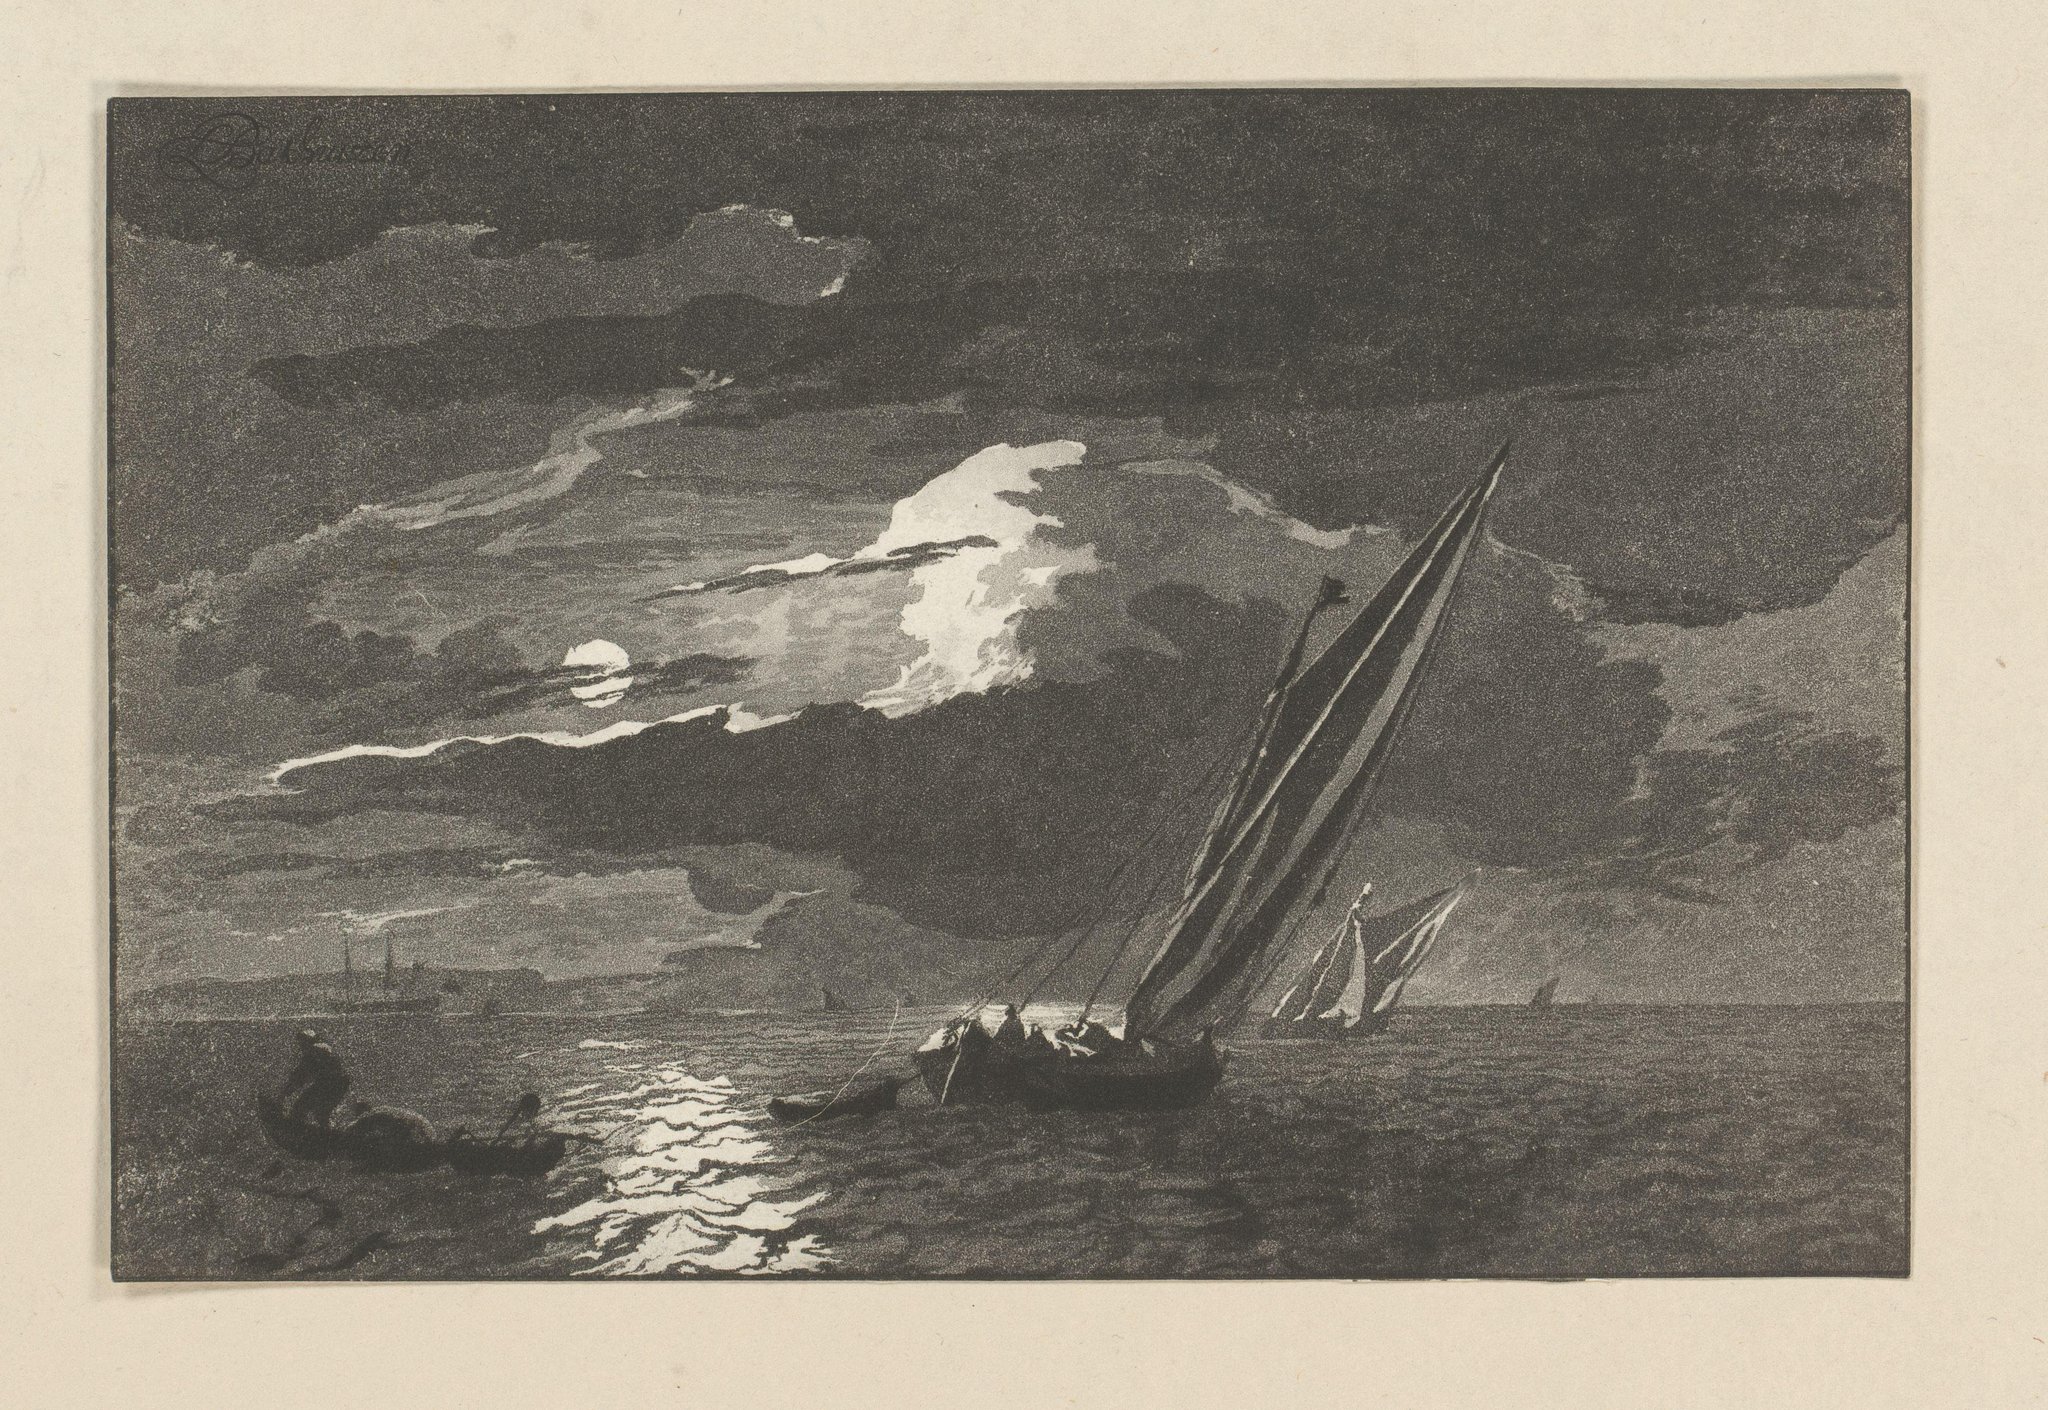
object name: print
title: Zeegezicht met volle maan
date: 1779-1781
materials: paper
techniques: transfer, print drawing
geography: amsterdam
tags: sailing-ship, sailing-boat, moonlight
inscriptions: collector's mark: ‘RIJKS / MUSM’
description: Op zee varen twee zeilschepen. Een visser haalt vanuit een sloep zijn netten binnen. De prent ligt los in een album, zie blad 33.